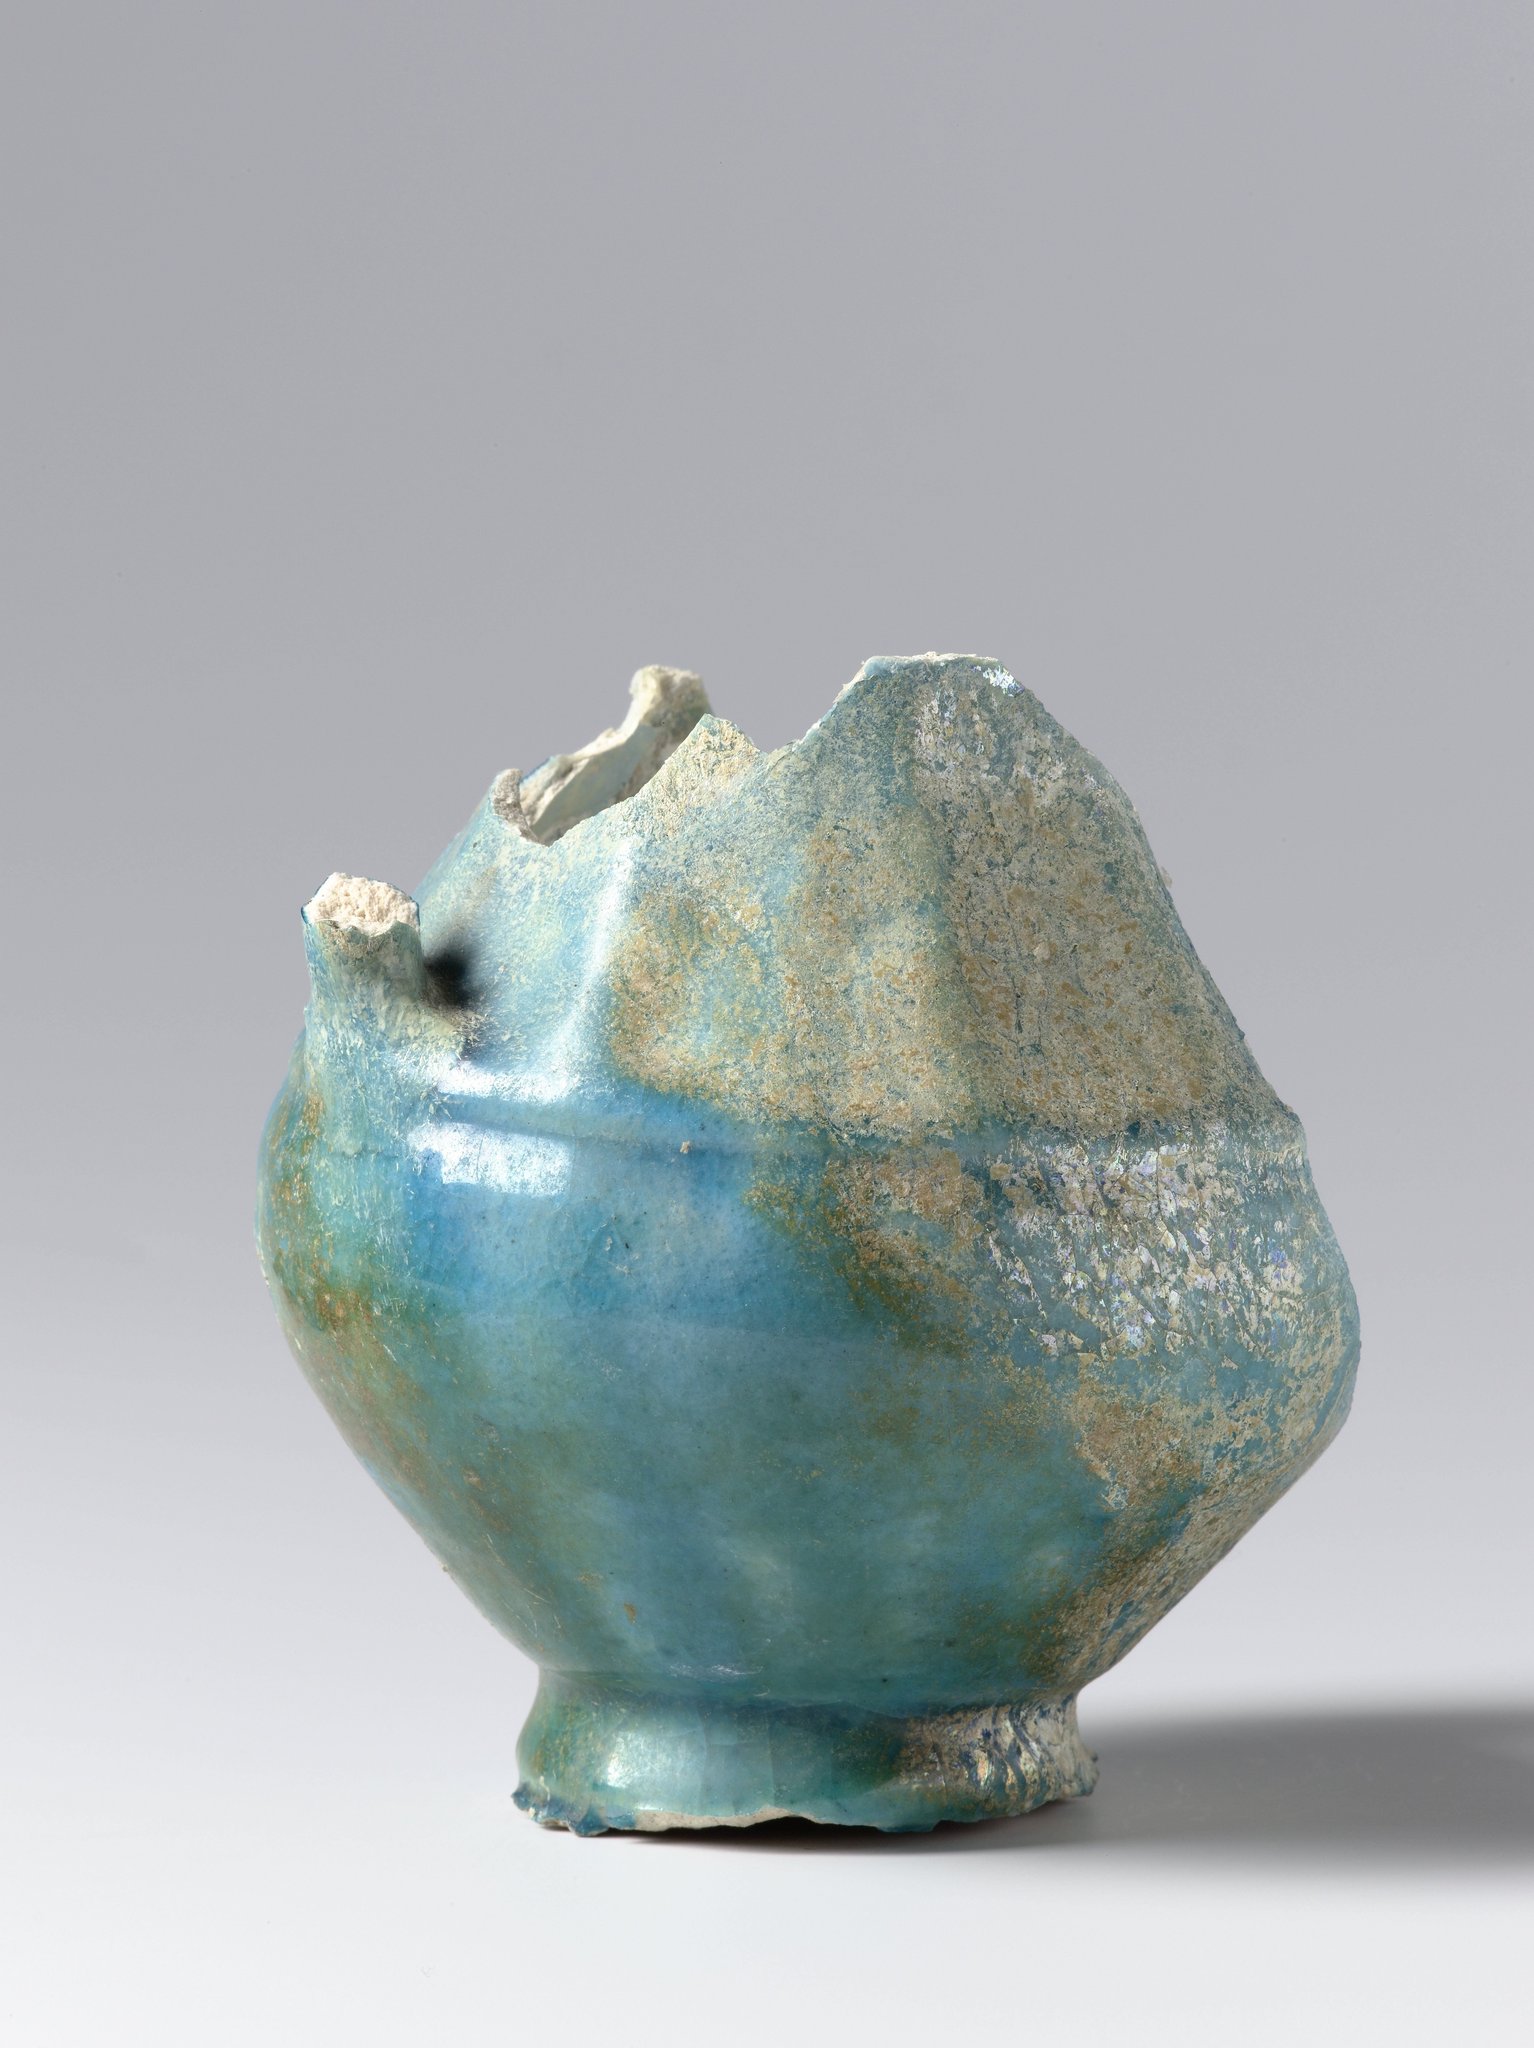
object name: fragment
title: Fragment of a ewer with a turquoise glaze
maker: Anonymous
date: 1100-1299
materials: earthenware, glaze, quartz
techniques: firing, turning, vitrification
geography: iran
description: Fragment van een kan van kwarts-fritgoed bedekt met een monochroom turquoise alkaliglazuur.